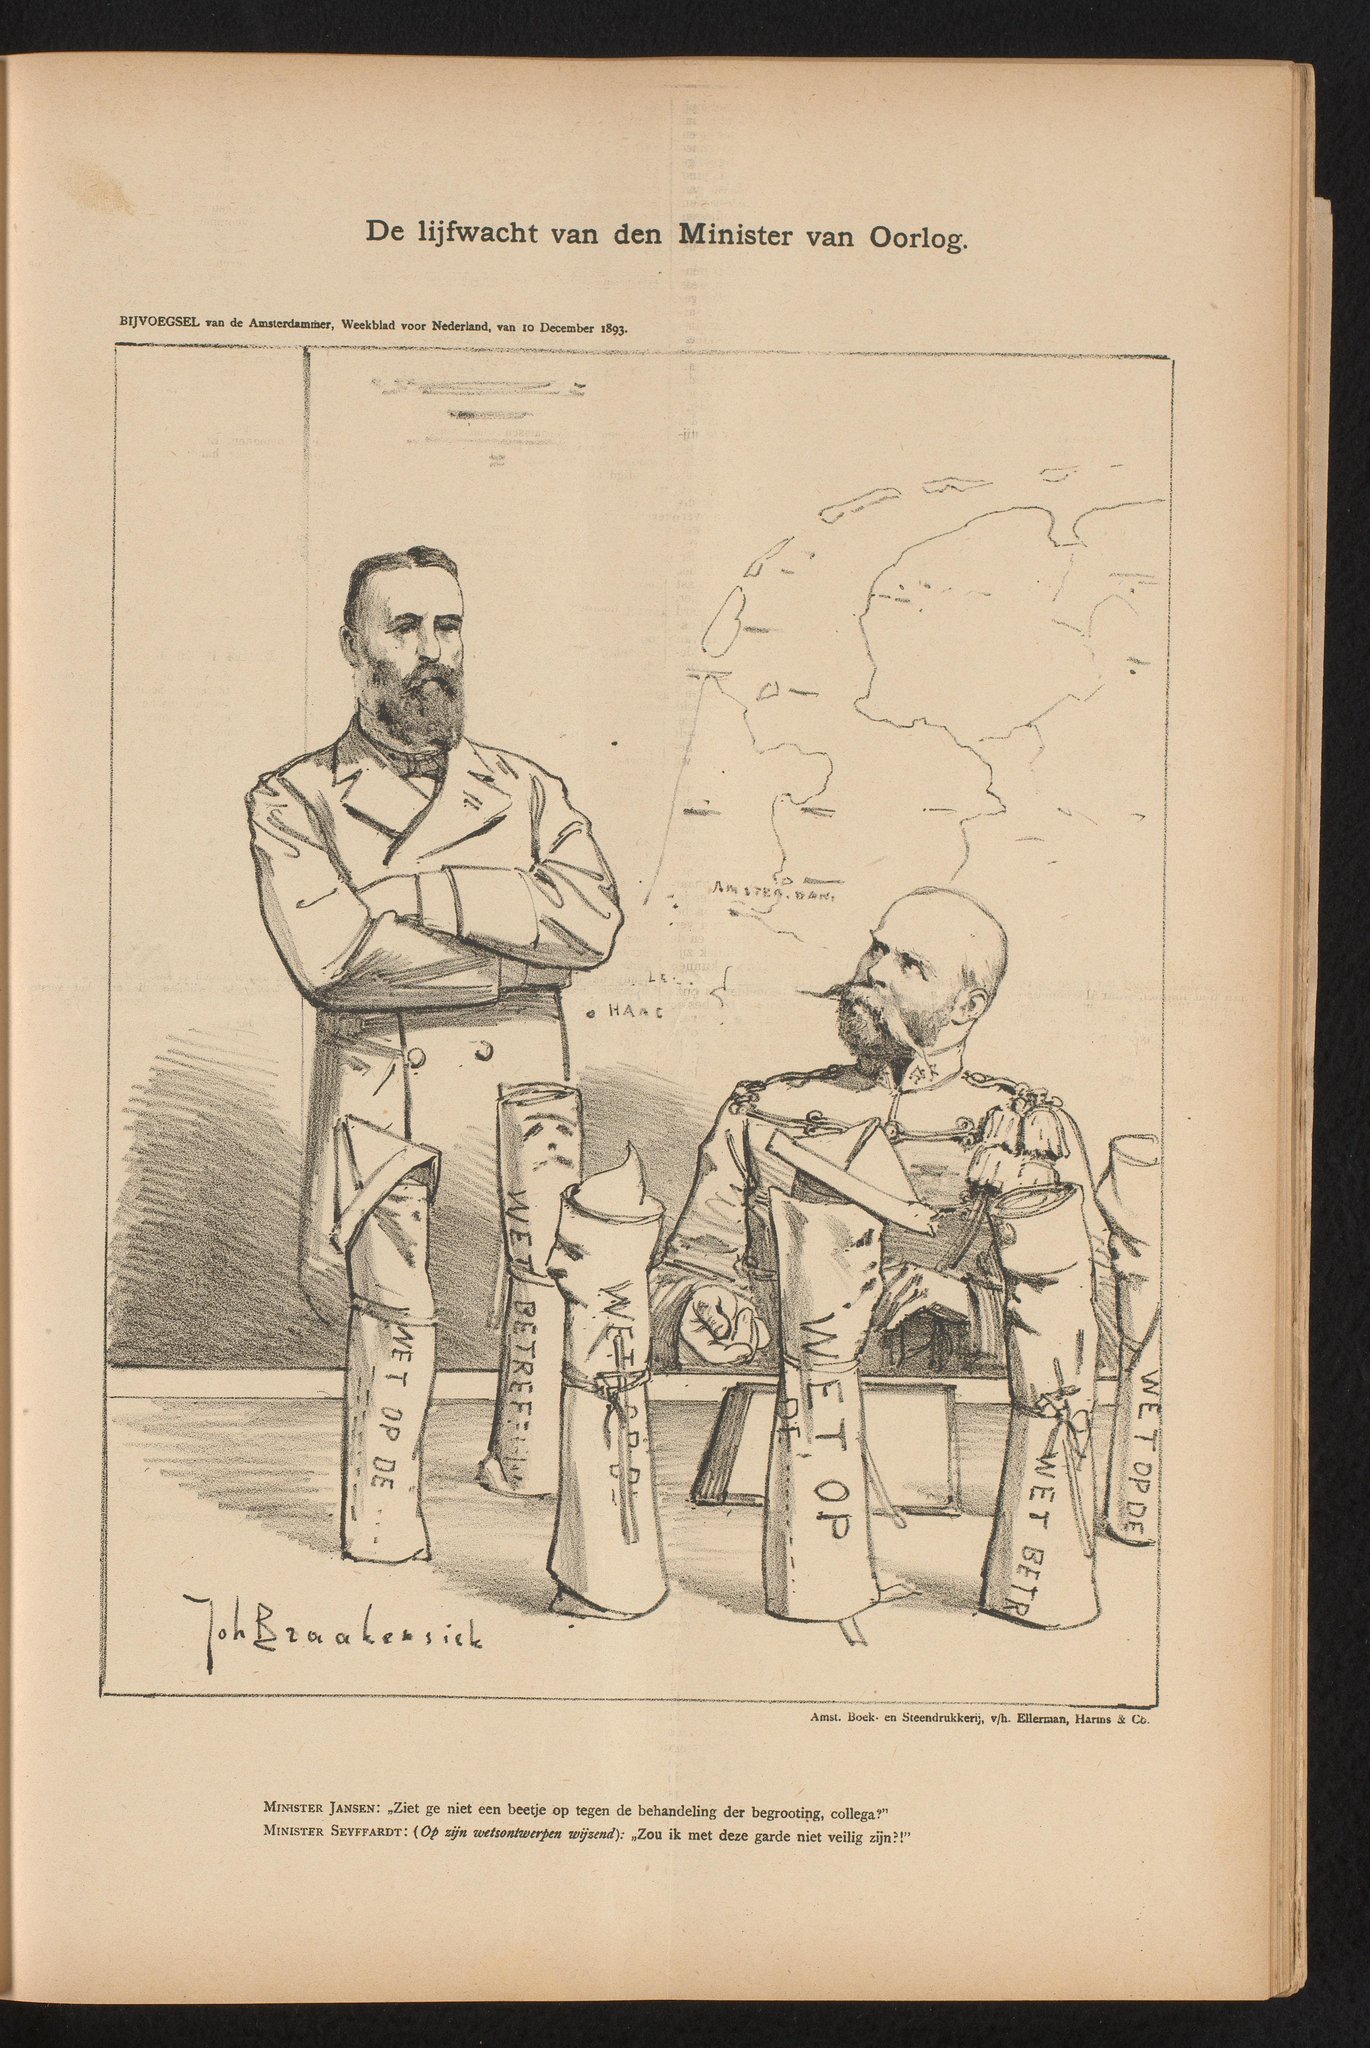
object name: cartoon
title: De lijfwacht van den Minister van Oorlog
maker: johan braakensiek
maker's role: draughtsman, print maker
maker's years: 1858-1940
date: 1893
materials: paper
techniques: lithograph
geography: netherlands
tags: politician, the hague, political caricatures and satires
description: Minister van Marine Jansen met als lijfwachten aangeklede en bewapende wetsontwerpen bij minister van Oorlog Seyffardt.